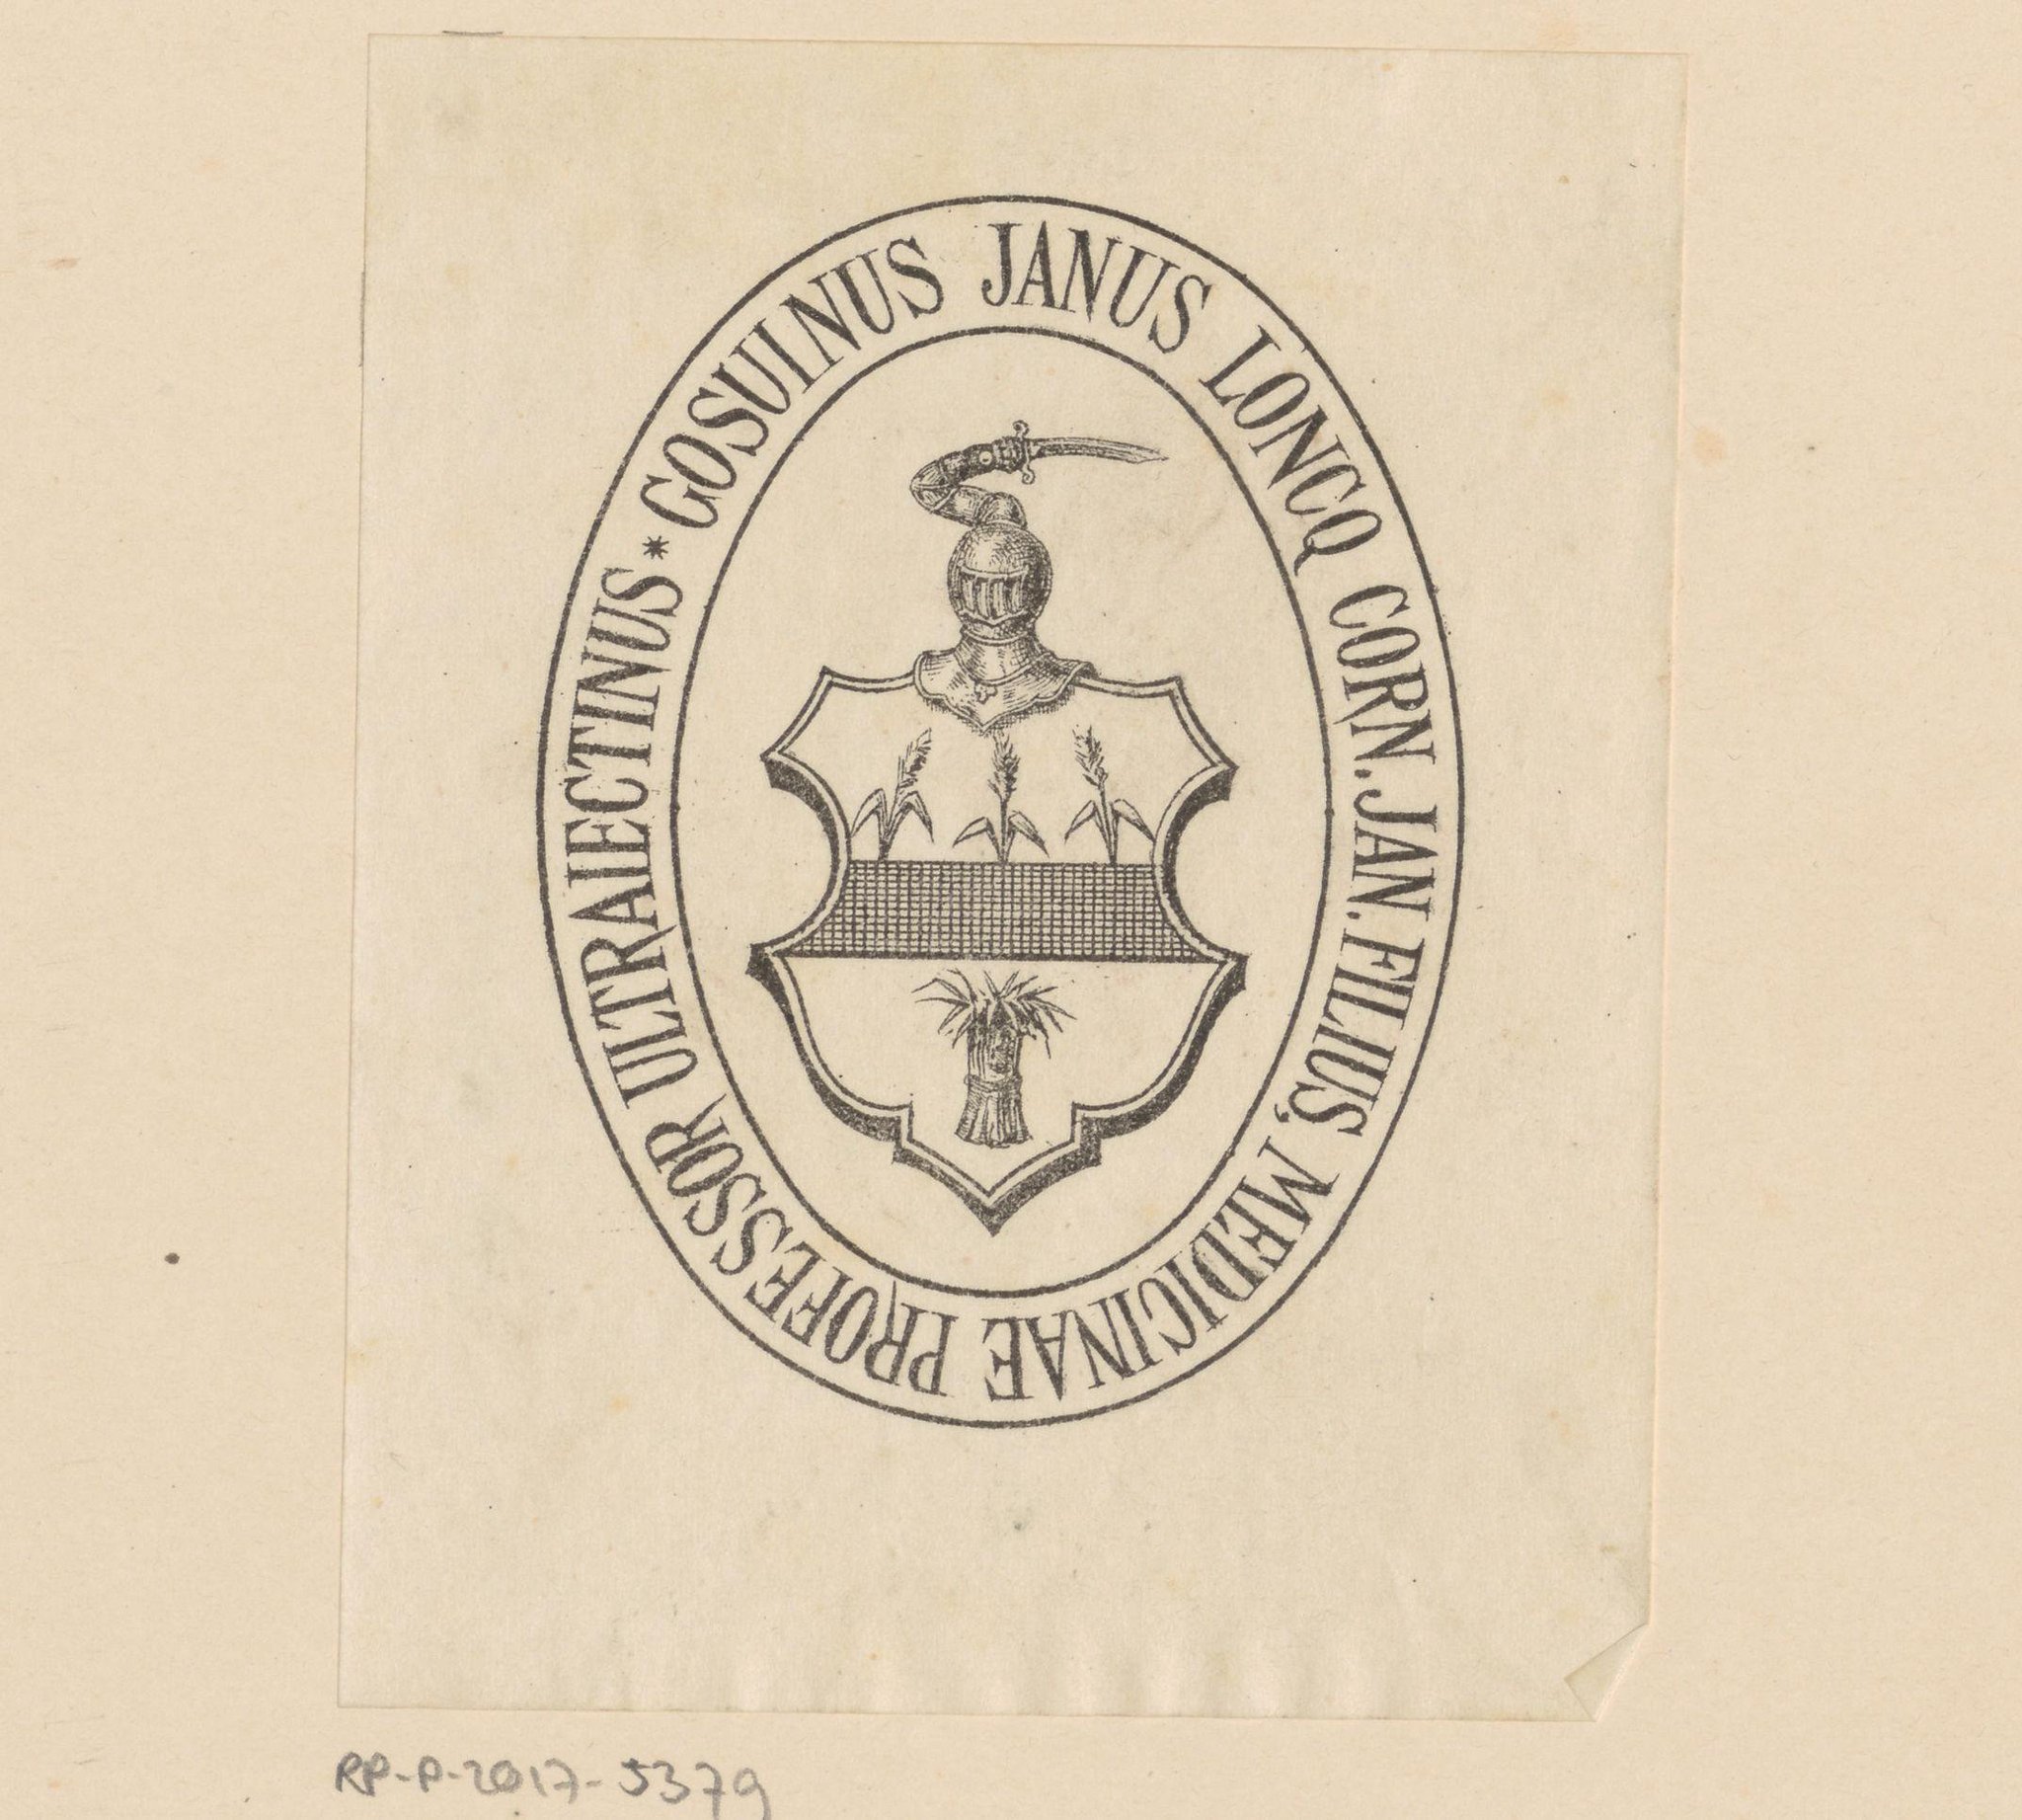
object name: bookplate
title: Ex libris van Gosuinus Janus Loncq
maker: Anonymous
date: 1768-1835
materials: paper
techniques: printing block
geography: netherlands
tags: utrecht, sheaf, armorial bearing, heraldry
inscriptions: inscription: ‘Rietstap, 2, 93.’